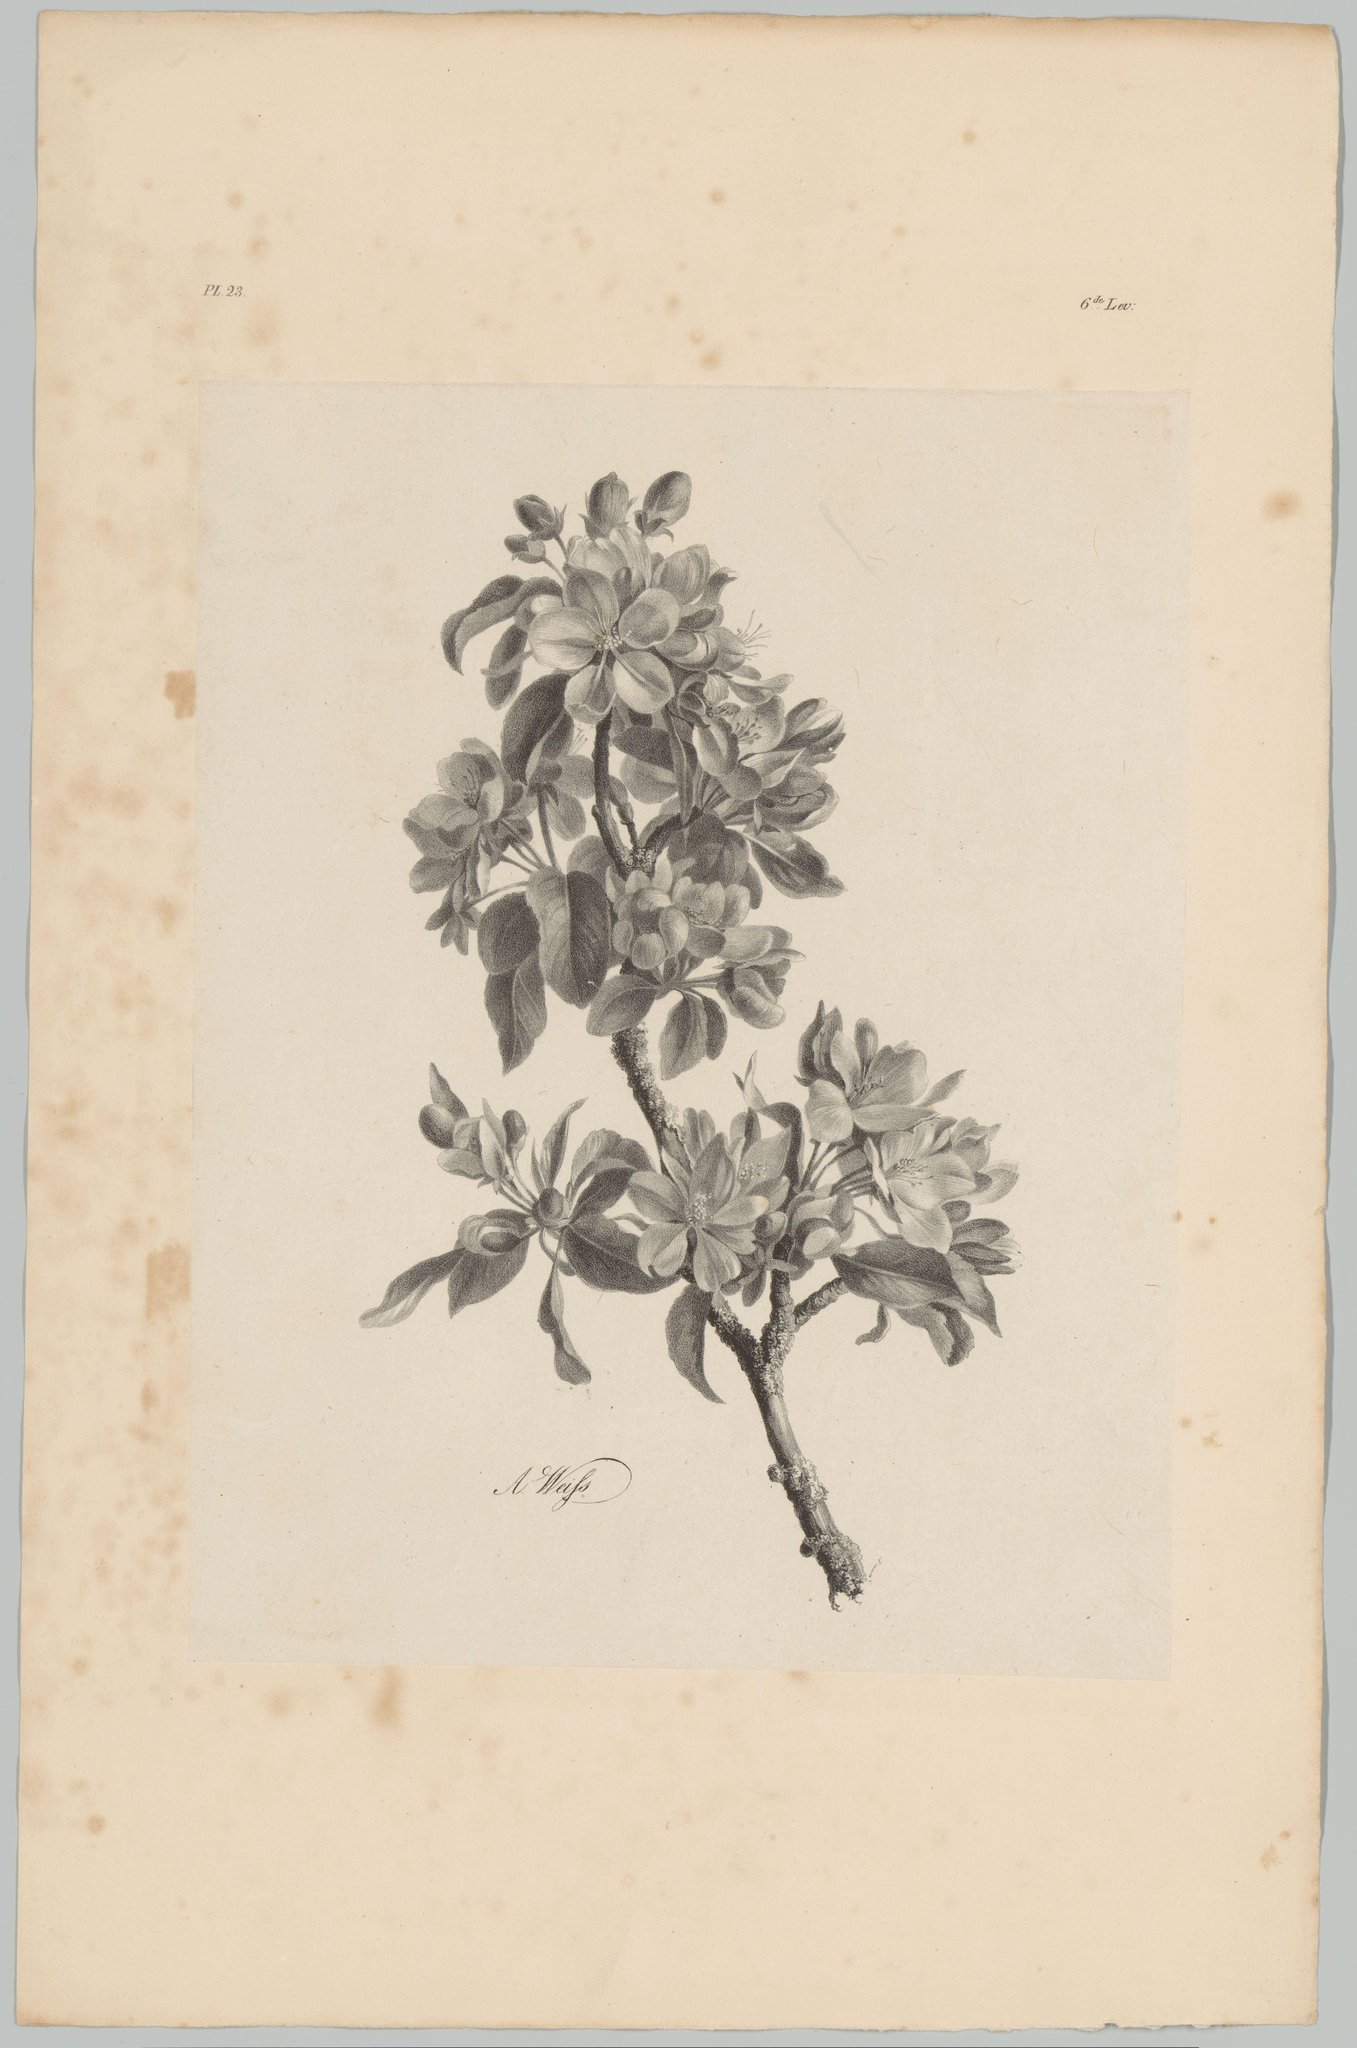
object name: print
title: Bloesemtak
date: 1820-1833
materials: paper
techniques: lithograph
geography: amsterdam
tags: flowers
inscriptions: collector's mark: Lugt 2228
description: Rechts boven genummerd 6de Lev. Onderdeel van een omslag met in totaal zevenenzeventig lithografieën van bloemen en fruit.